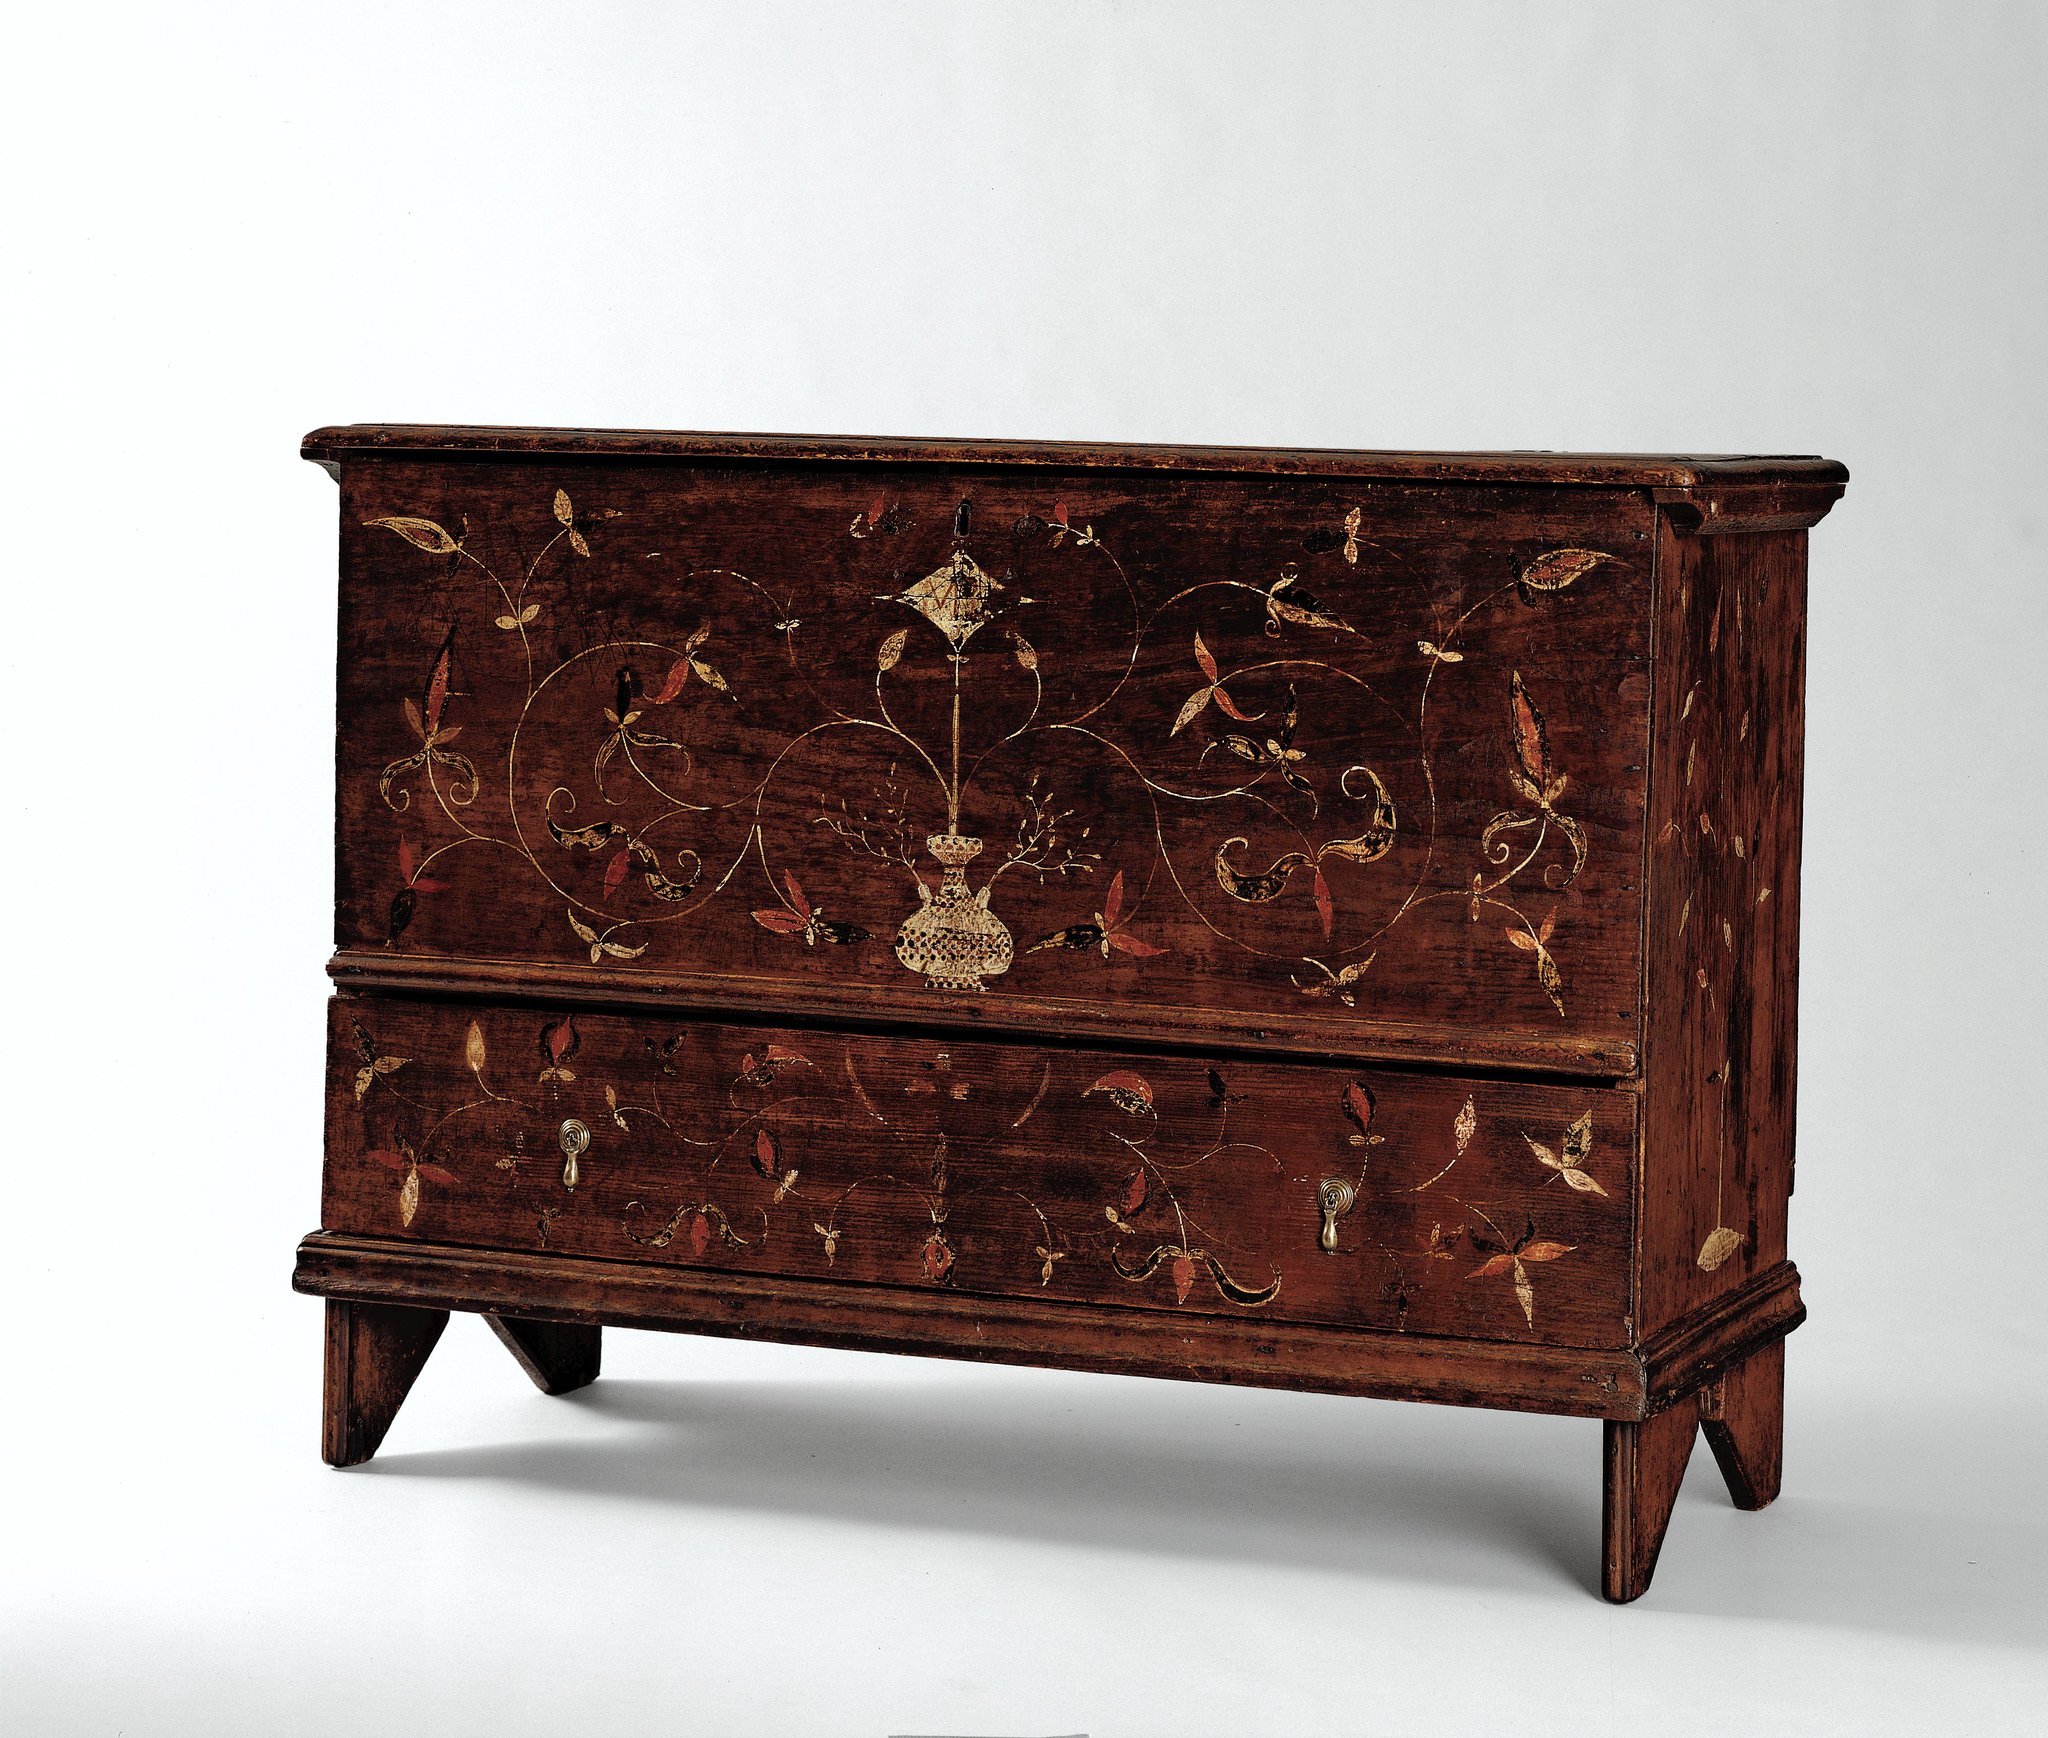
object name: chest of drawer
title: Chest with drawer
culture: american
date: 1720-1735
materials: wood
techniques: painting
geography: united states